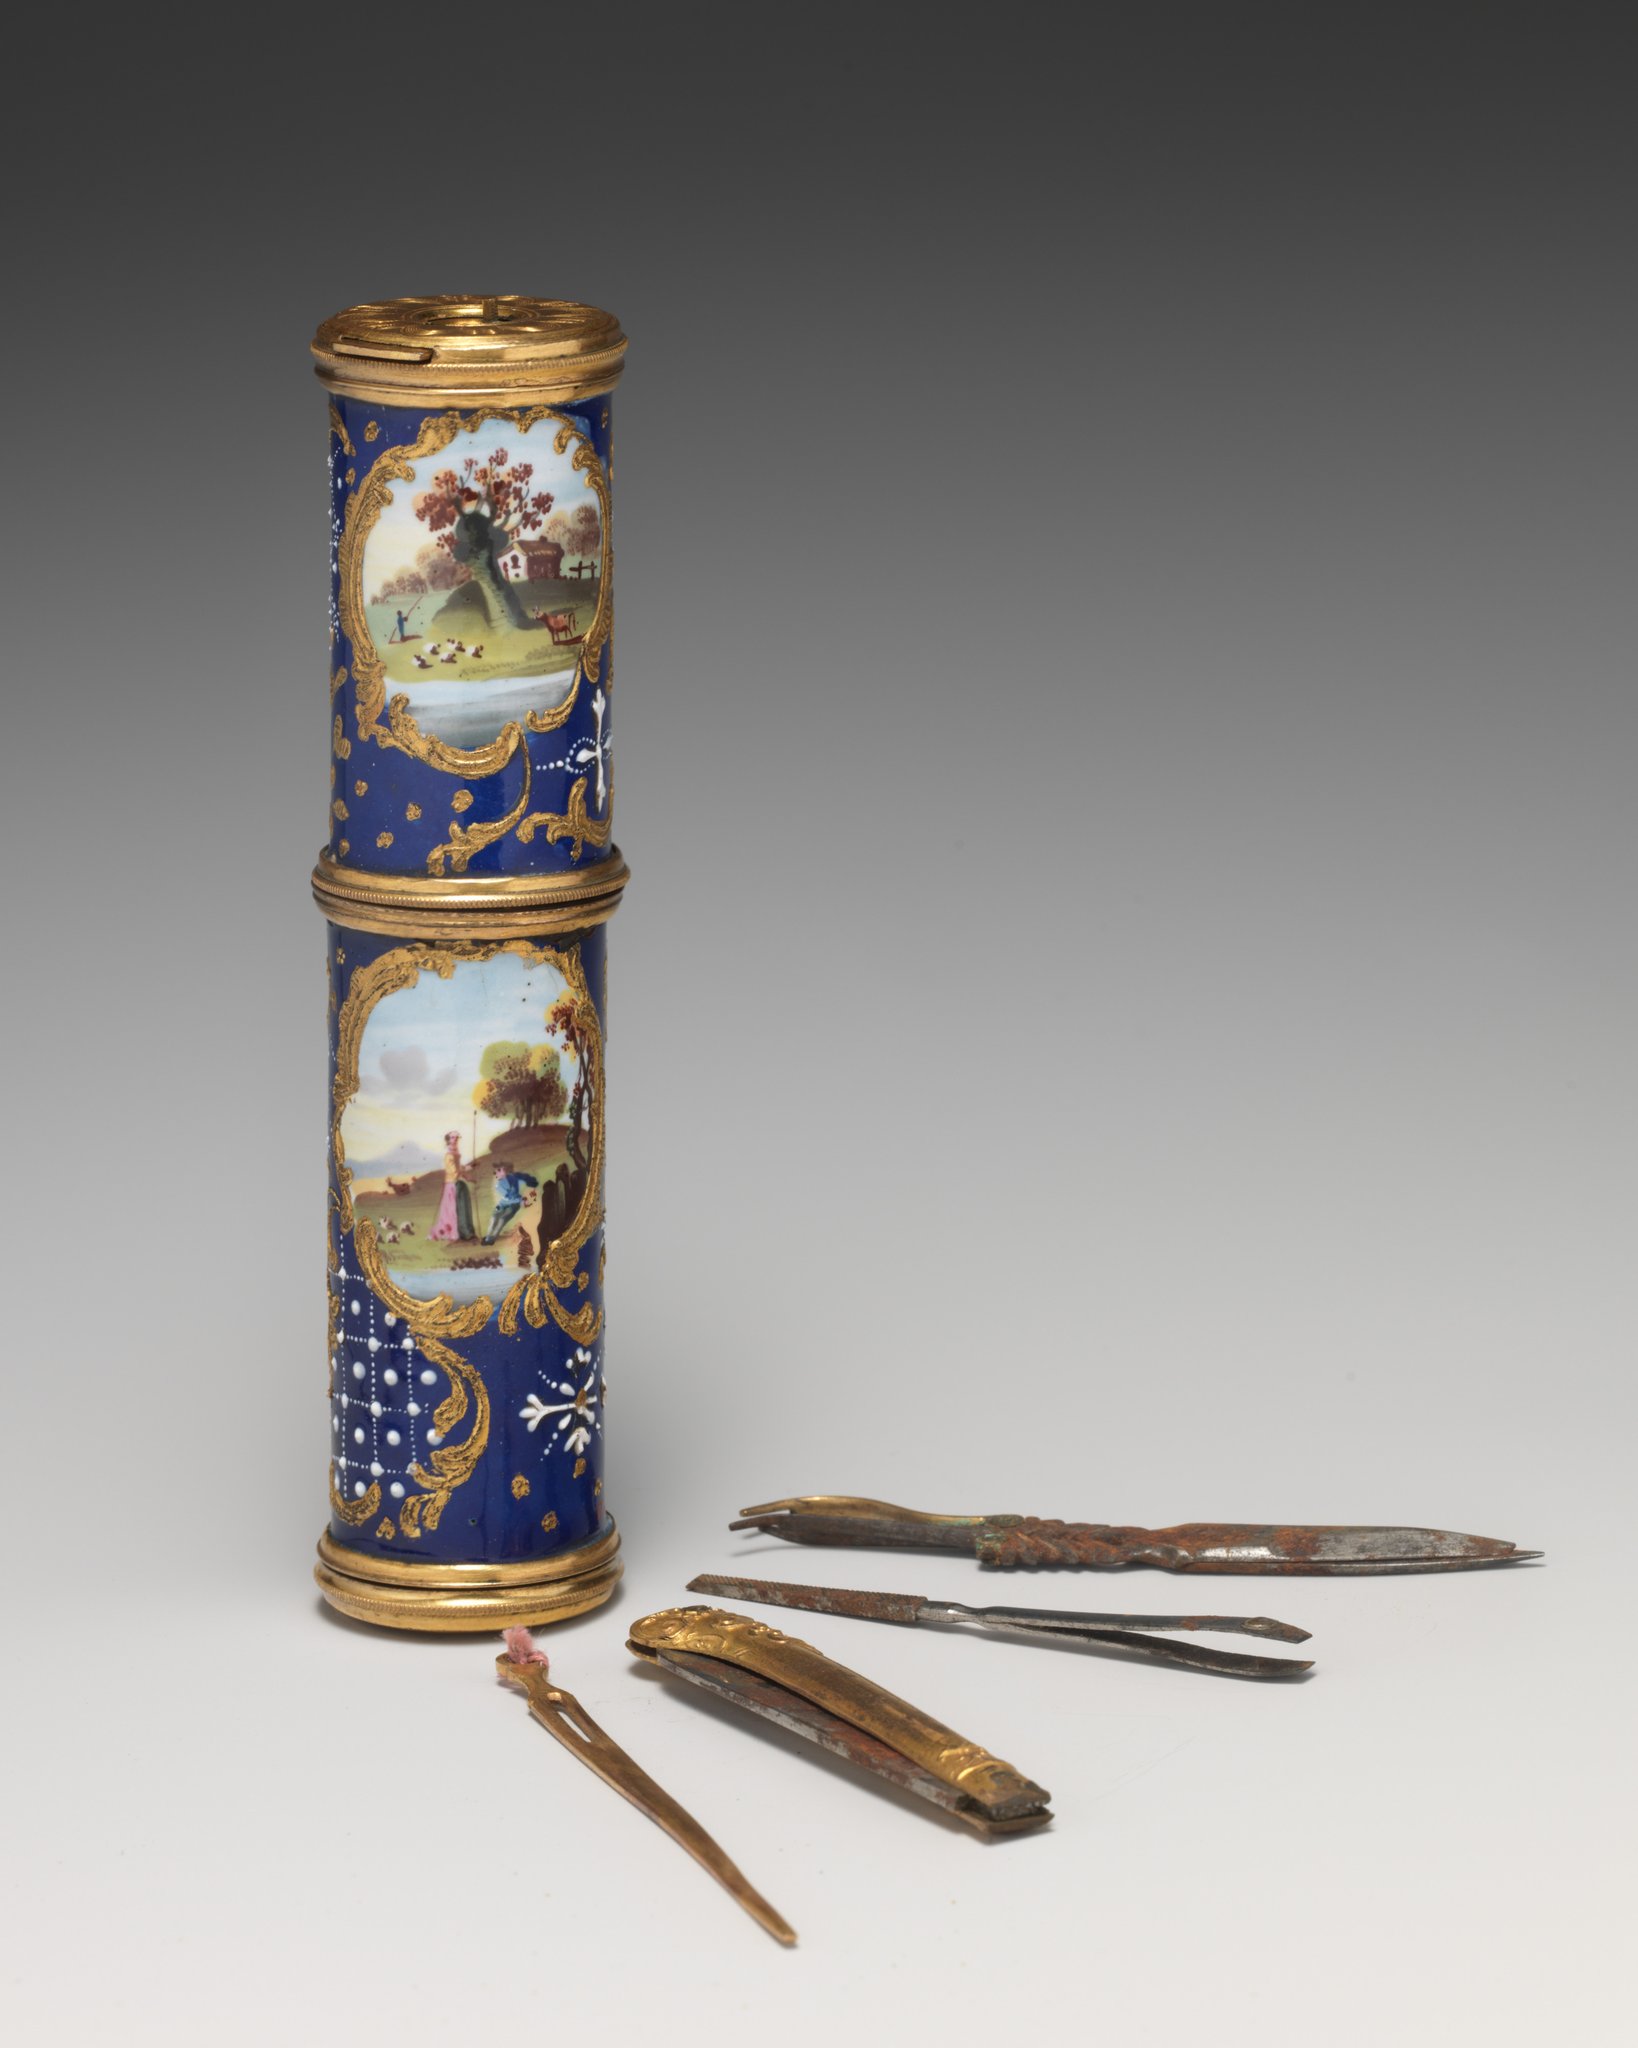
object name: nécessaire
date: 1765-1770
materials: copper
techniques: enamel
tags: human figures,animals,houses,landscapes